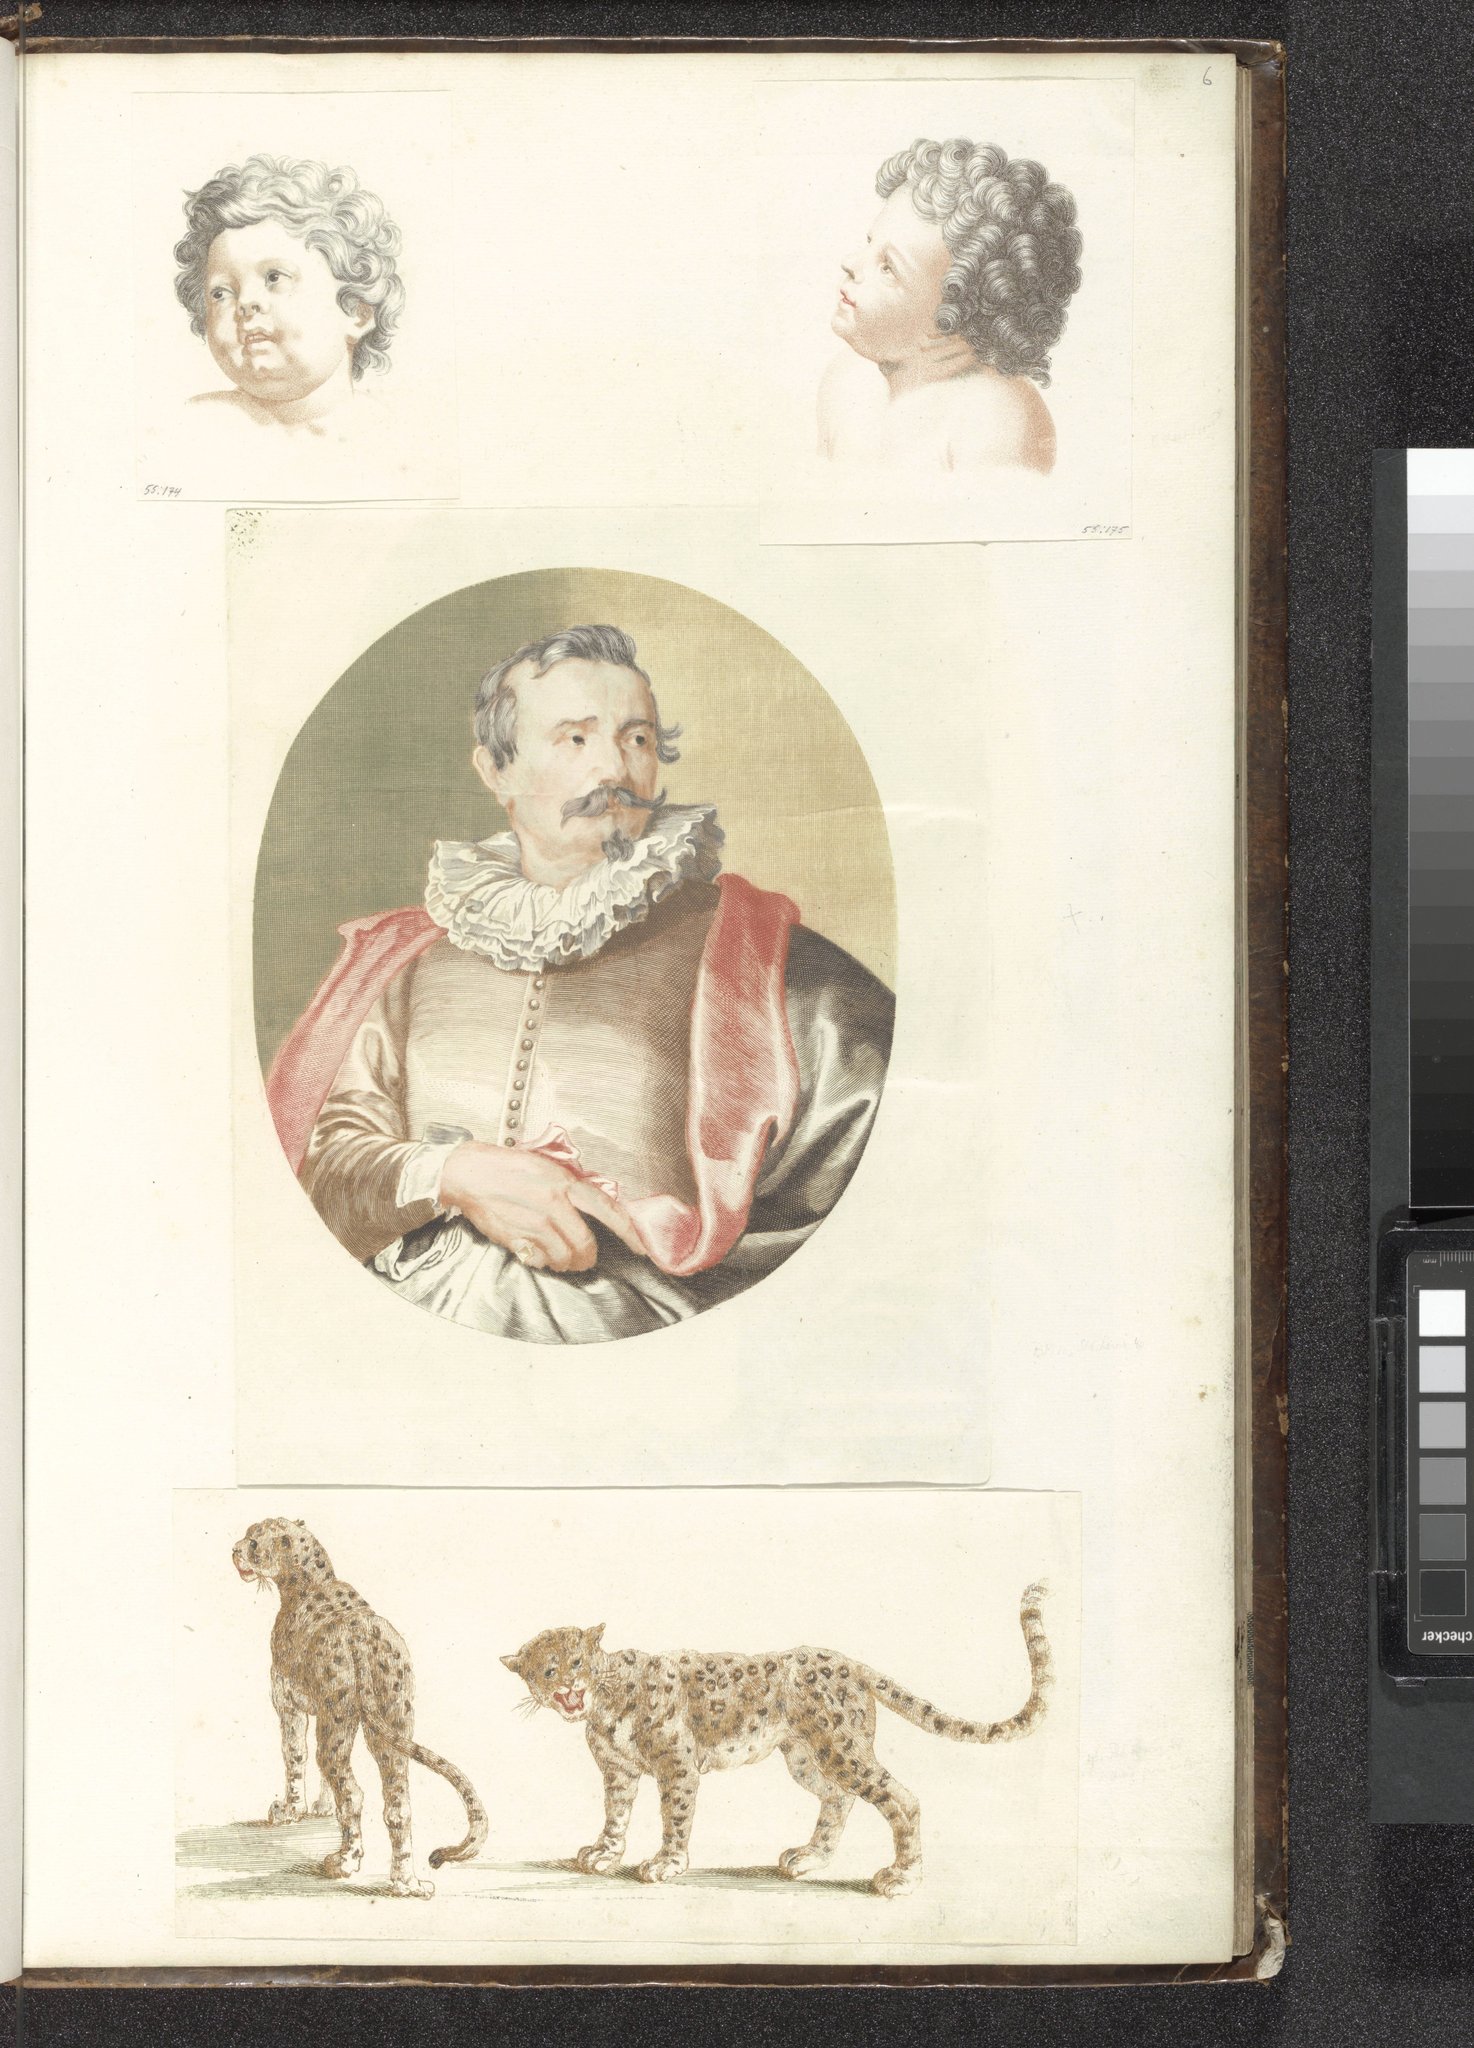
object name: album leaf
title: Kindergezicht opkijkend naar links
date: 1688-1698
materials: paper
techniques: etching, lithography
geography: netherlands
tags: face, cupids: 'amores', 'amoretti', 'putti'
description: Gezicht van een kind of putto, opkijkend naar links. Deze prent maakt deel uit van een album.